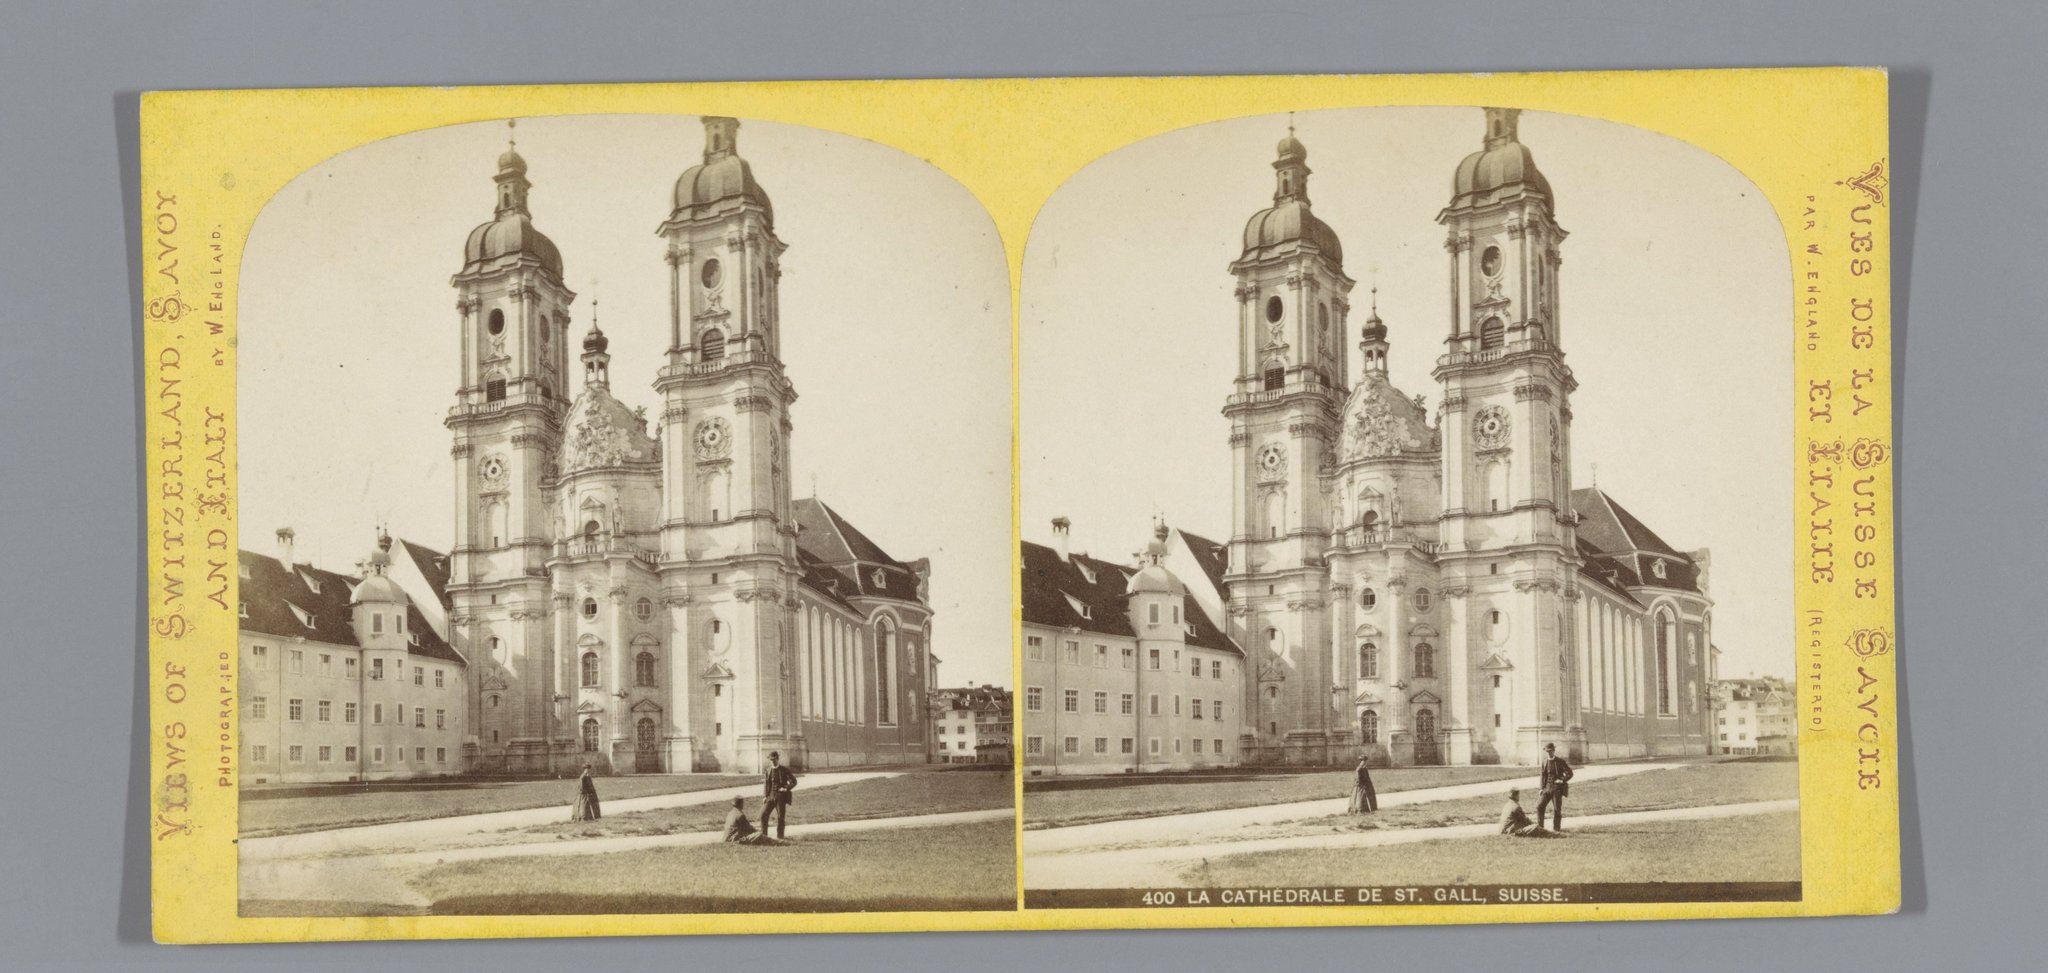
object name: stereograph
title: Le Cathédrale de St Gall, Suisse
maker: william england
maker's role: fotograaf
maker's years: 1816-1896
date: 1850-1880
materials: cardboard, photographic support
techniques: albumen print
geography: sankt gallen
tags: church (exterior)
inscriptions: inscription: ‘Vues de la Suisse Savoie et Italie’, number: ‘400’